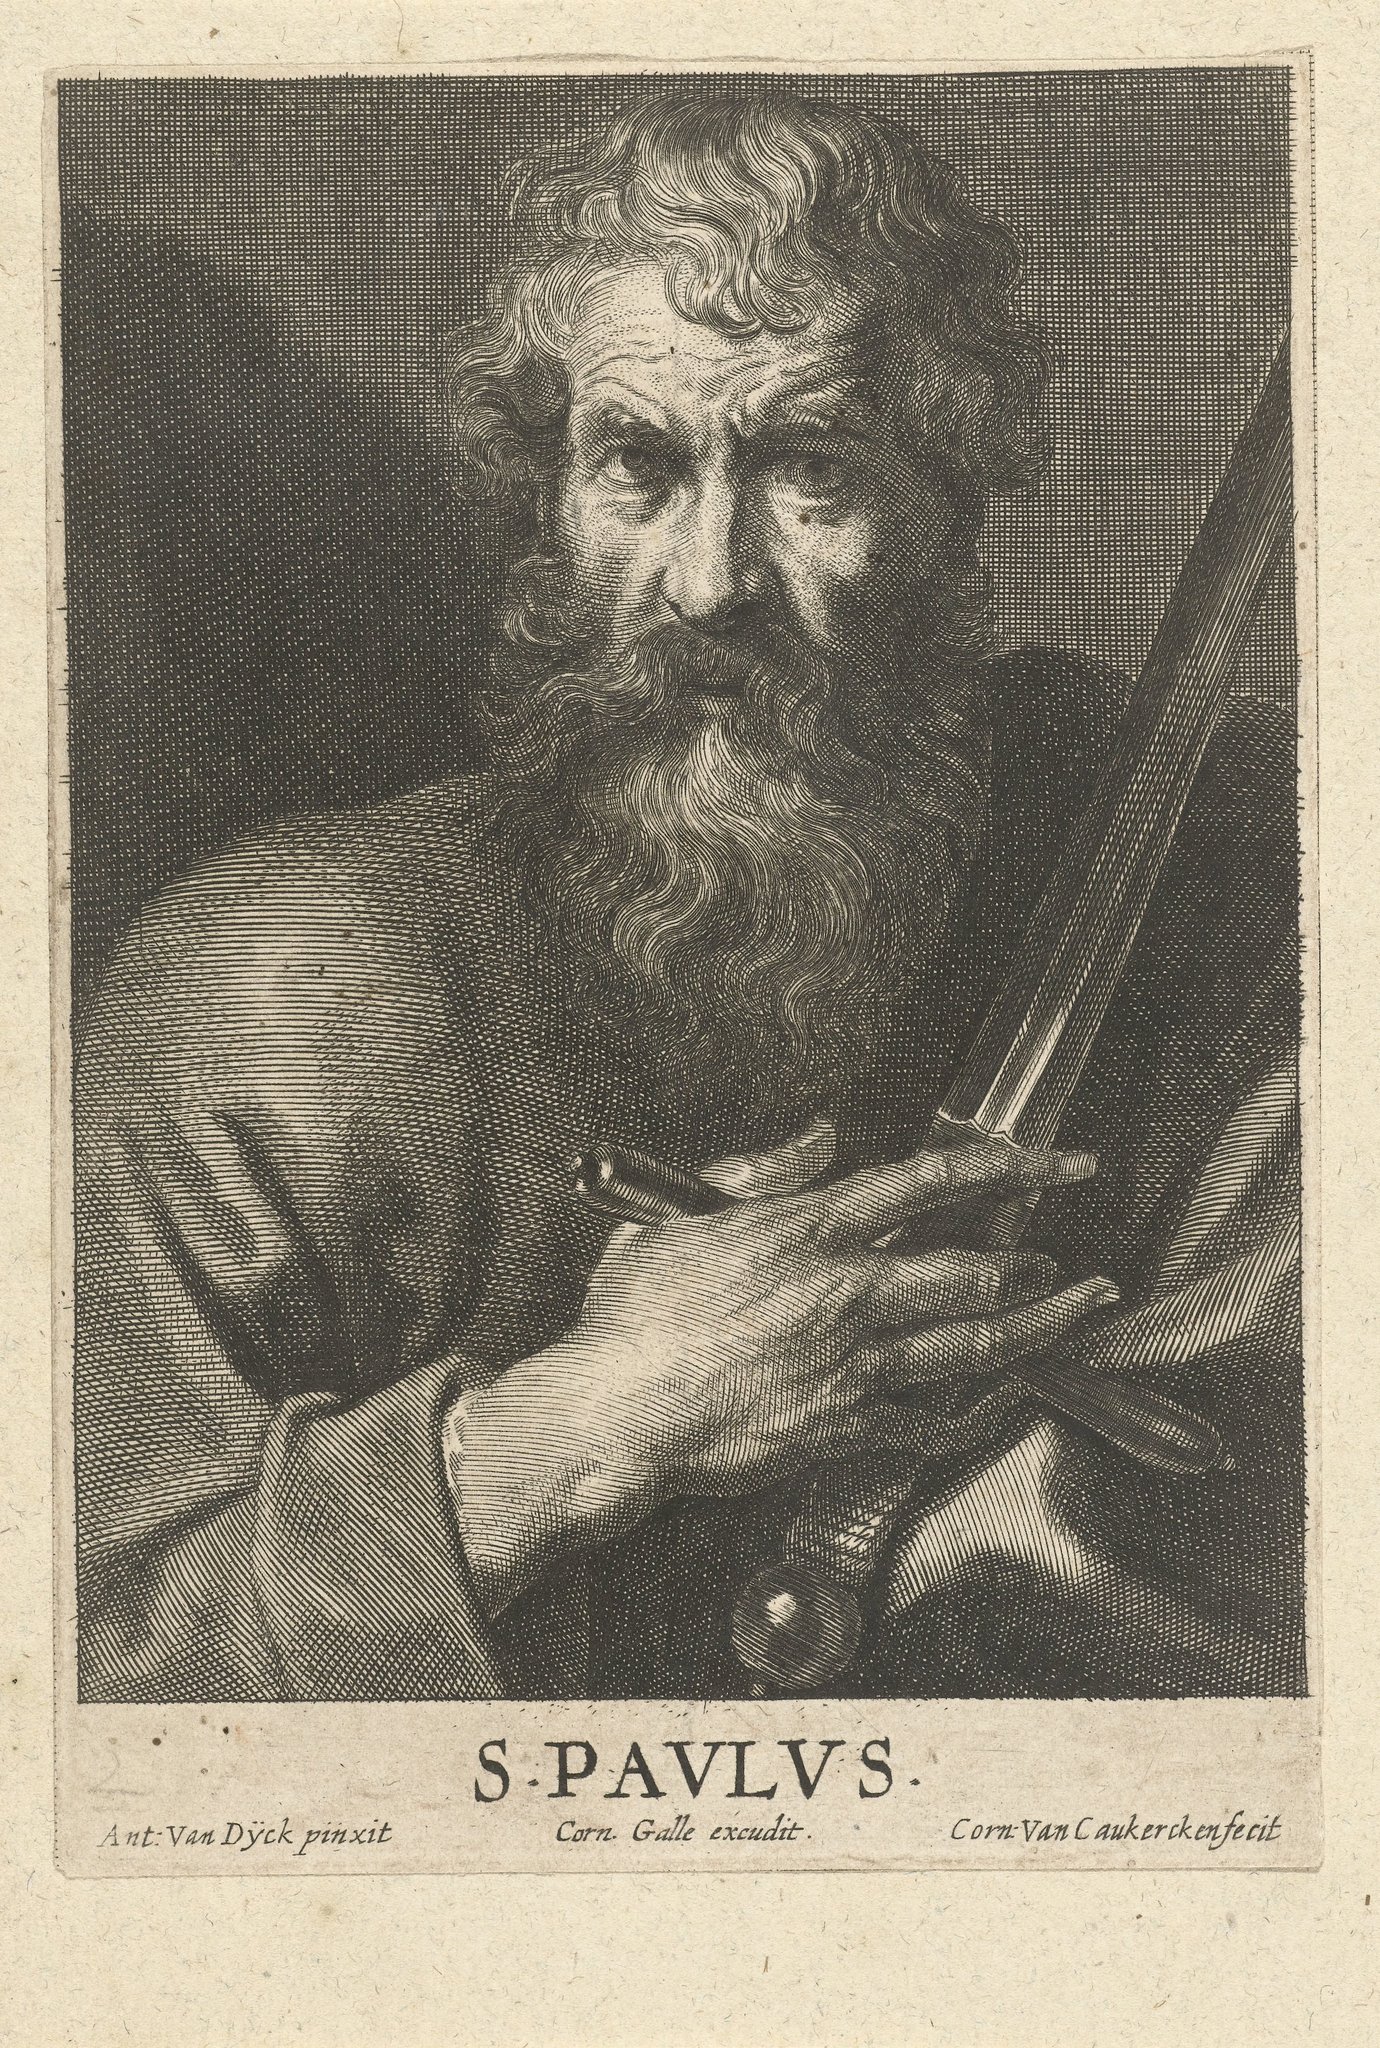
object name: print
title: Paulus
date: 1640-1680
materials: paper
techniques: engraving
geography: antwerp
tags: the apostle paul of tarsus; possible attributes: book, scroll, sword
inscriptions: collector's mark: Lugt 2233